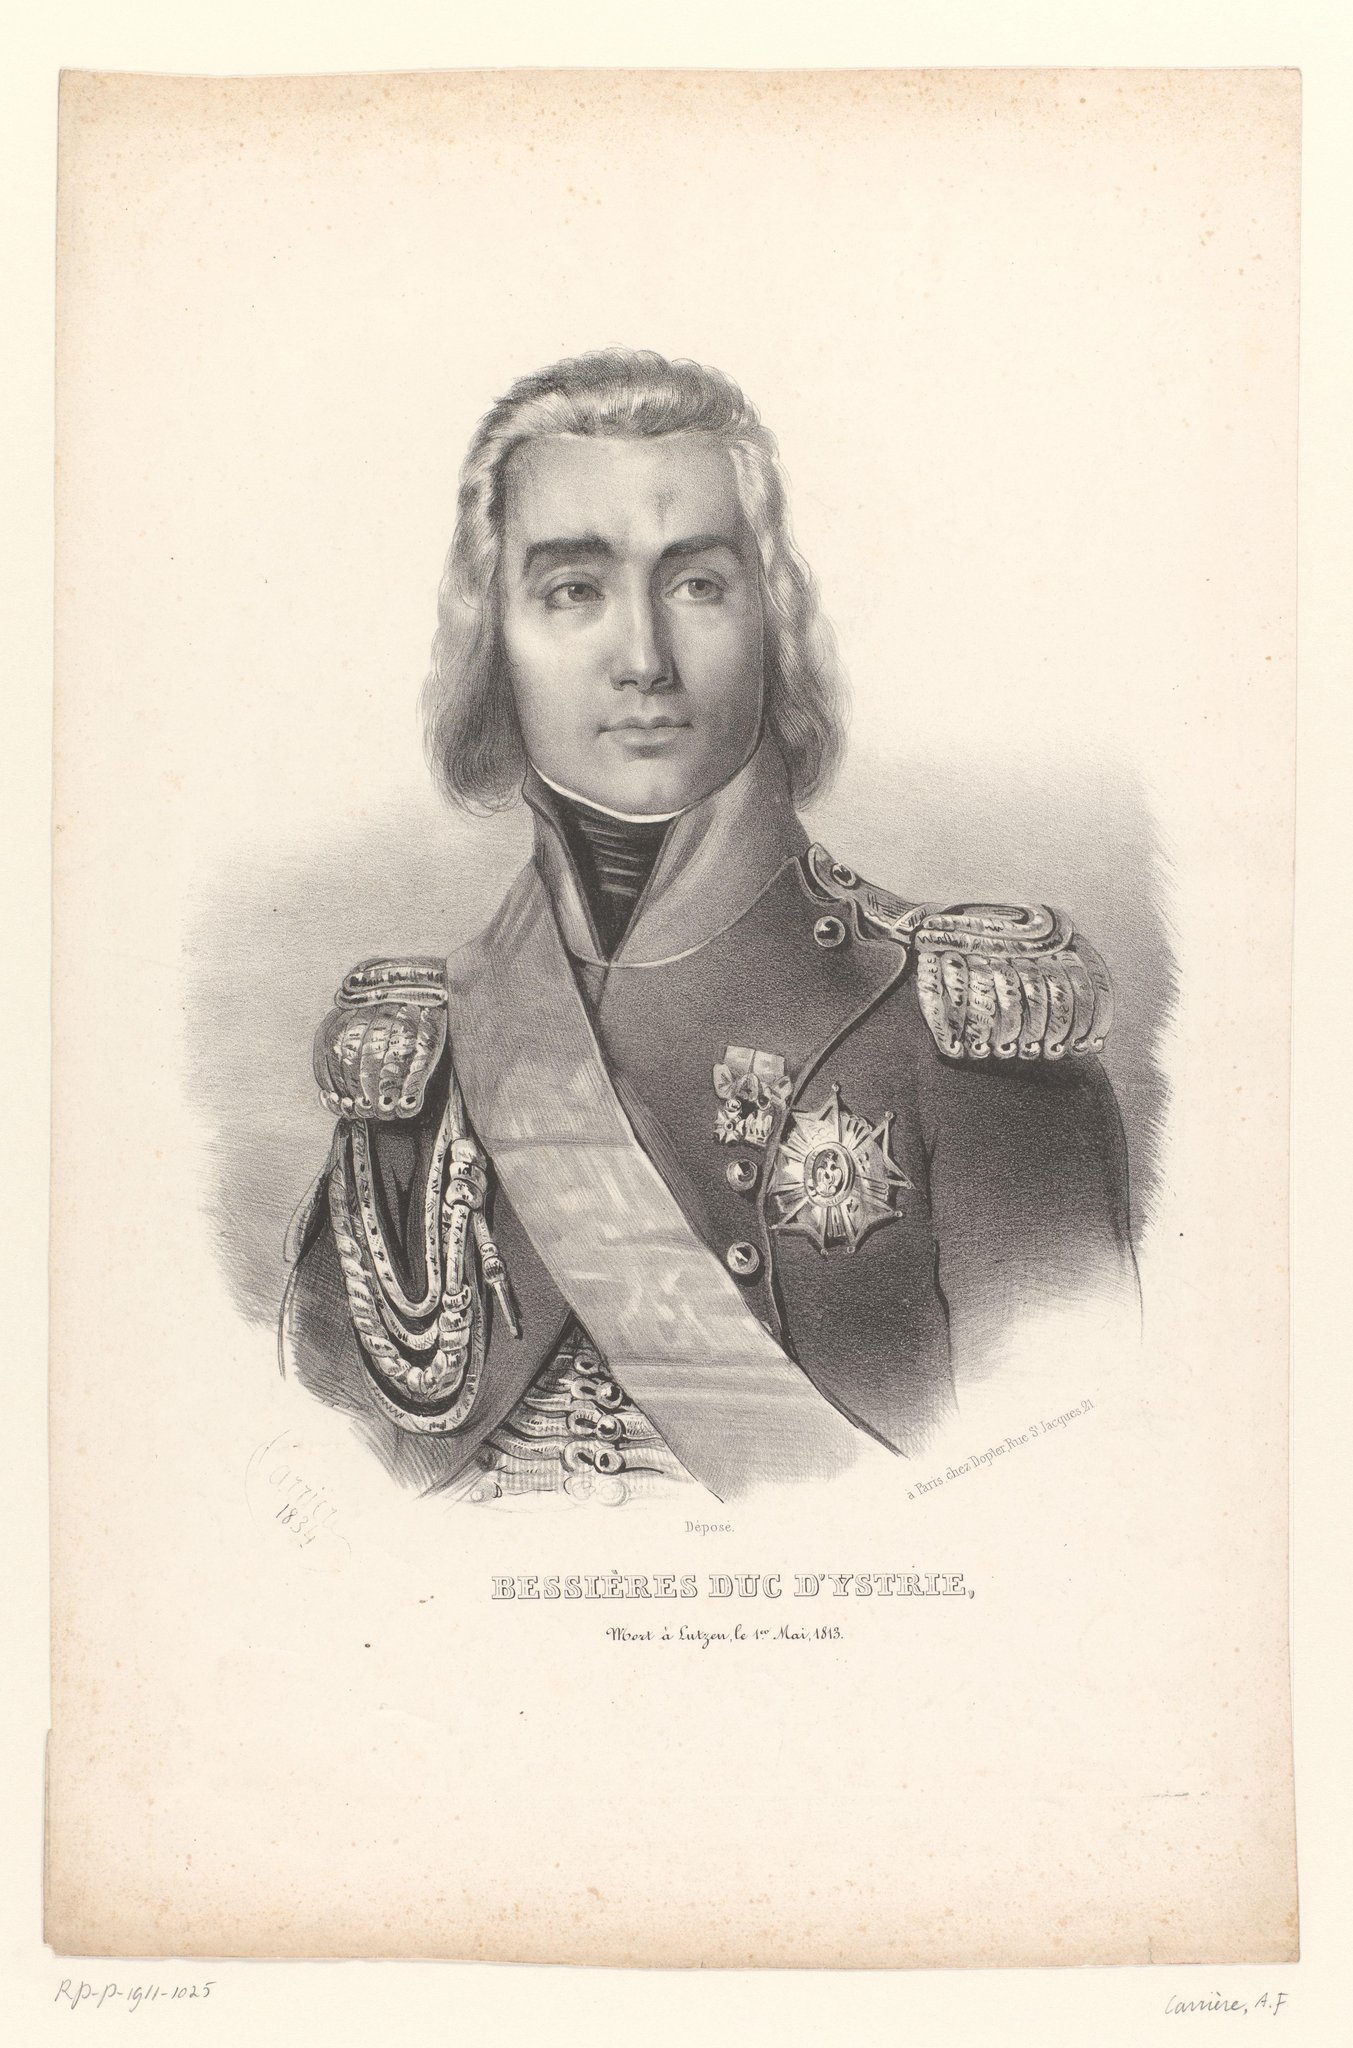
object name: print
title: Bessières duc d'Ystrie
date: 1834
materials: paper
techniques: lithograph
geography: paris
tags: historical persons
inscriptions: collector's mark: Lugt 2228a